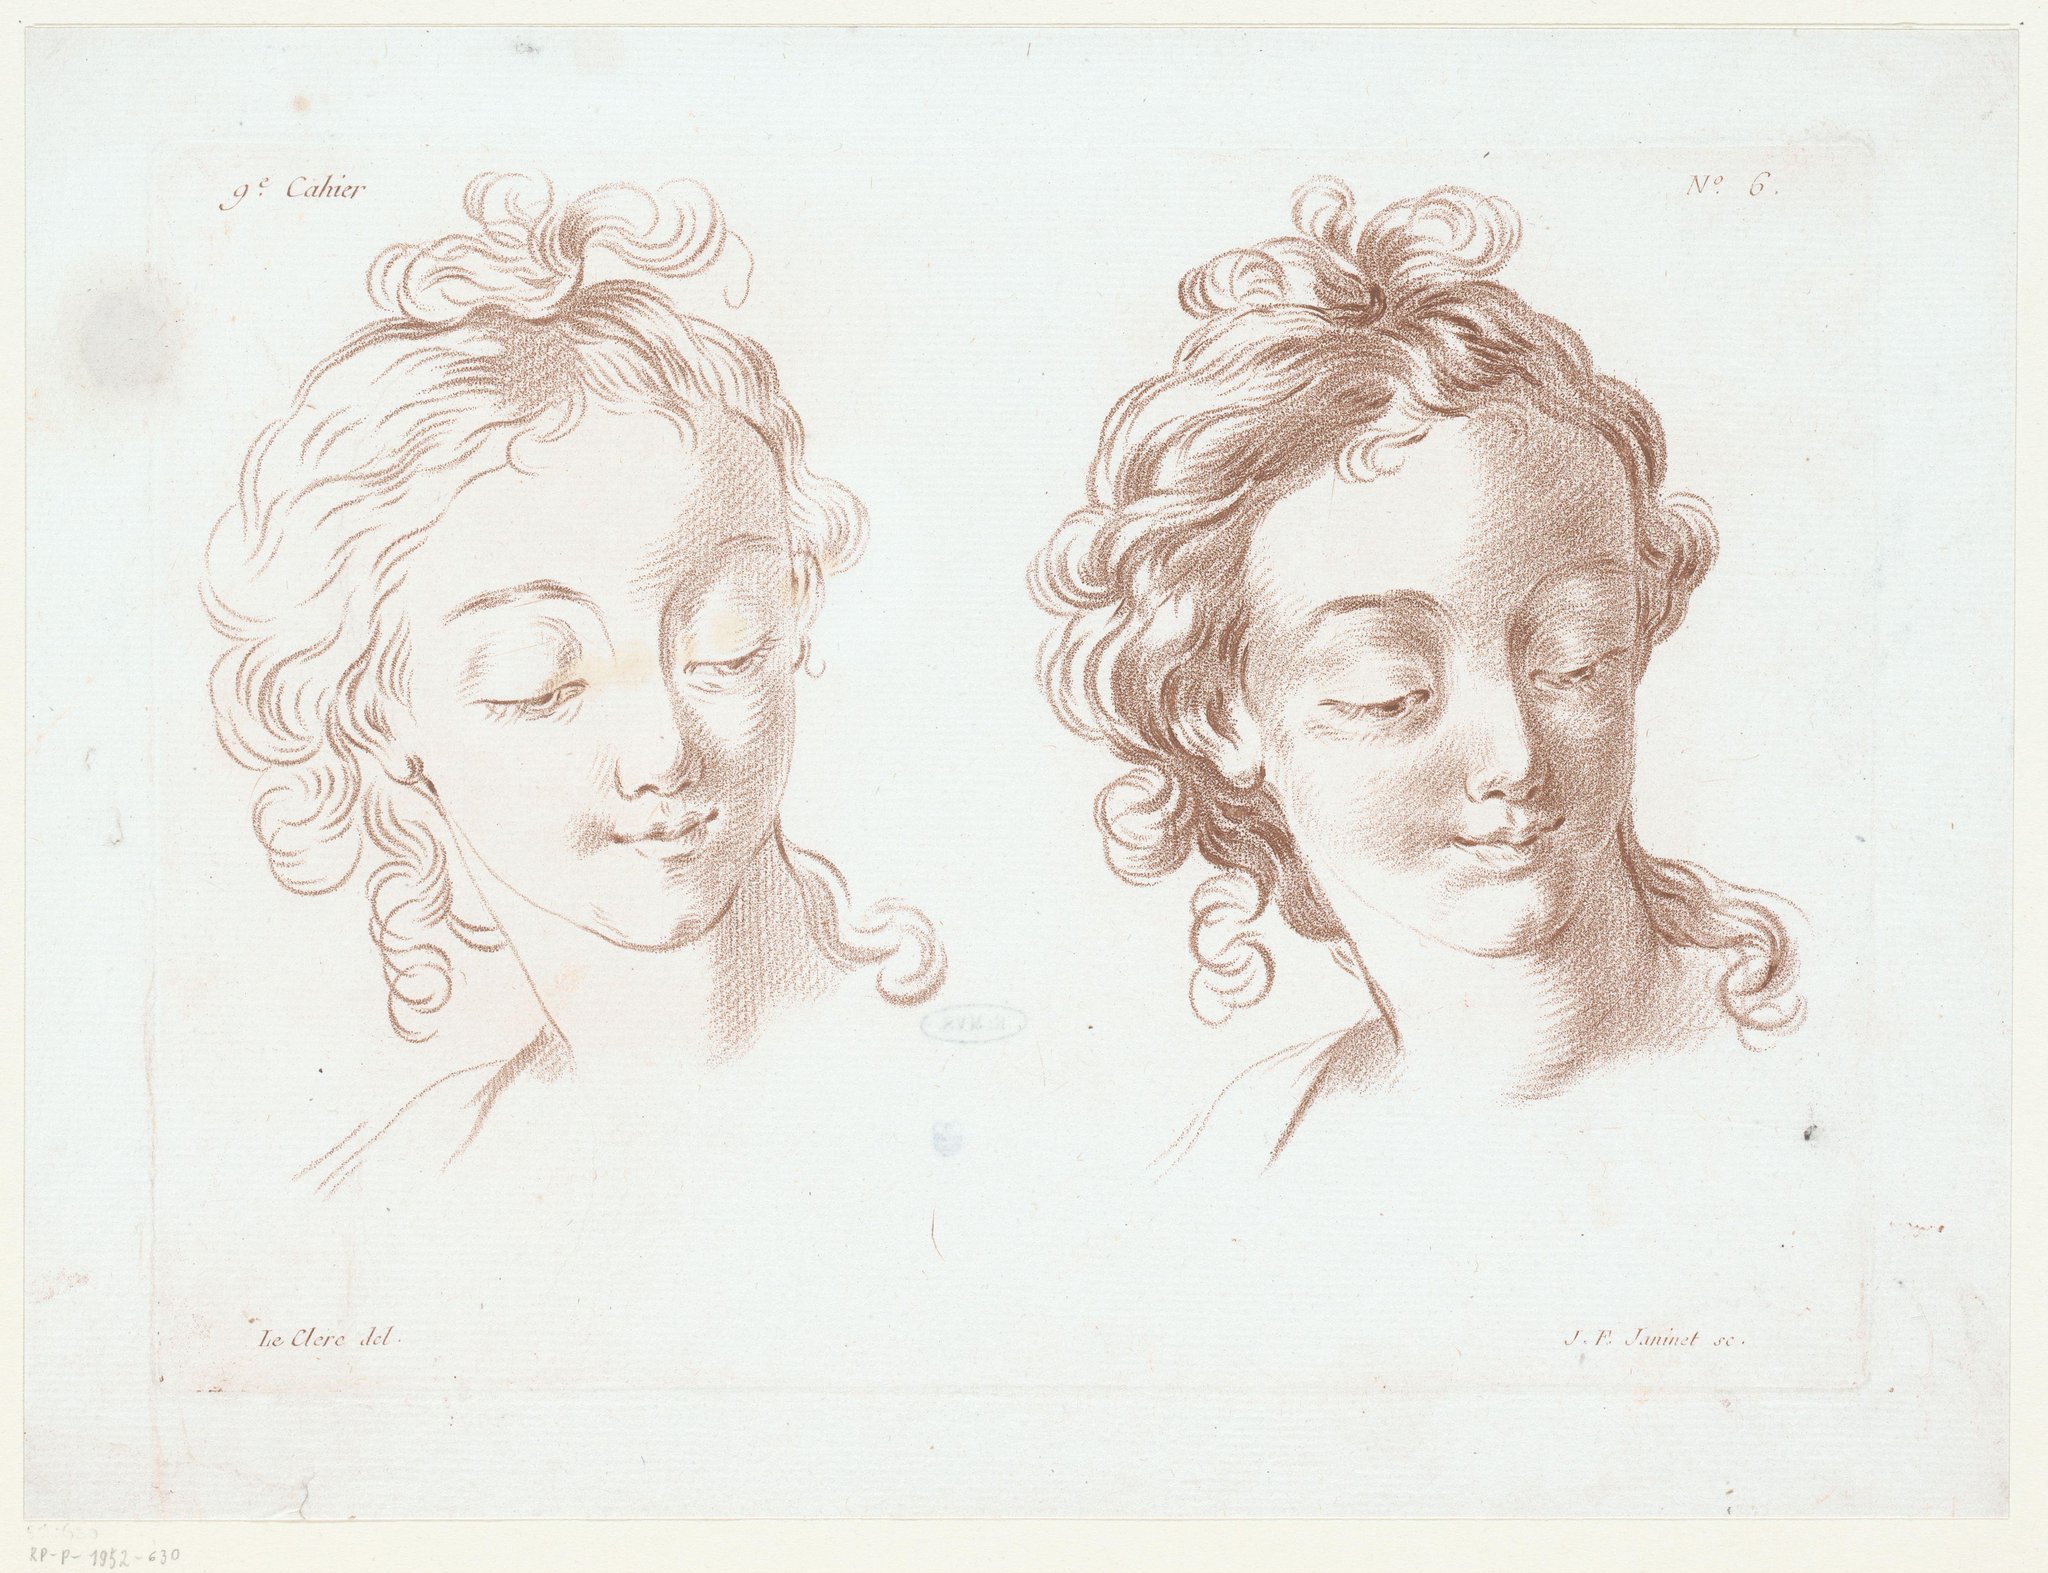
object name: print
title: Composities met menselijke lichaamsdelen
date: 1773-1814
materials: paper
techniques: printmaking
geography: paris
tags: head (human) - aa - female human figure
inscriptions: watermark, collector's mark: Lugt 2760, collector's mark: Lugt 2228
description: Deze prent maakt deel uit van een album dat uit minstens elf delen bestaat. Dit is het zesde blad uit het negende album. Waarschijnlijk dienden deze albums als voorbeeld voor tekenaars, schilders en graveurs.